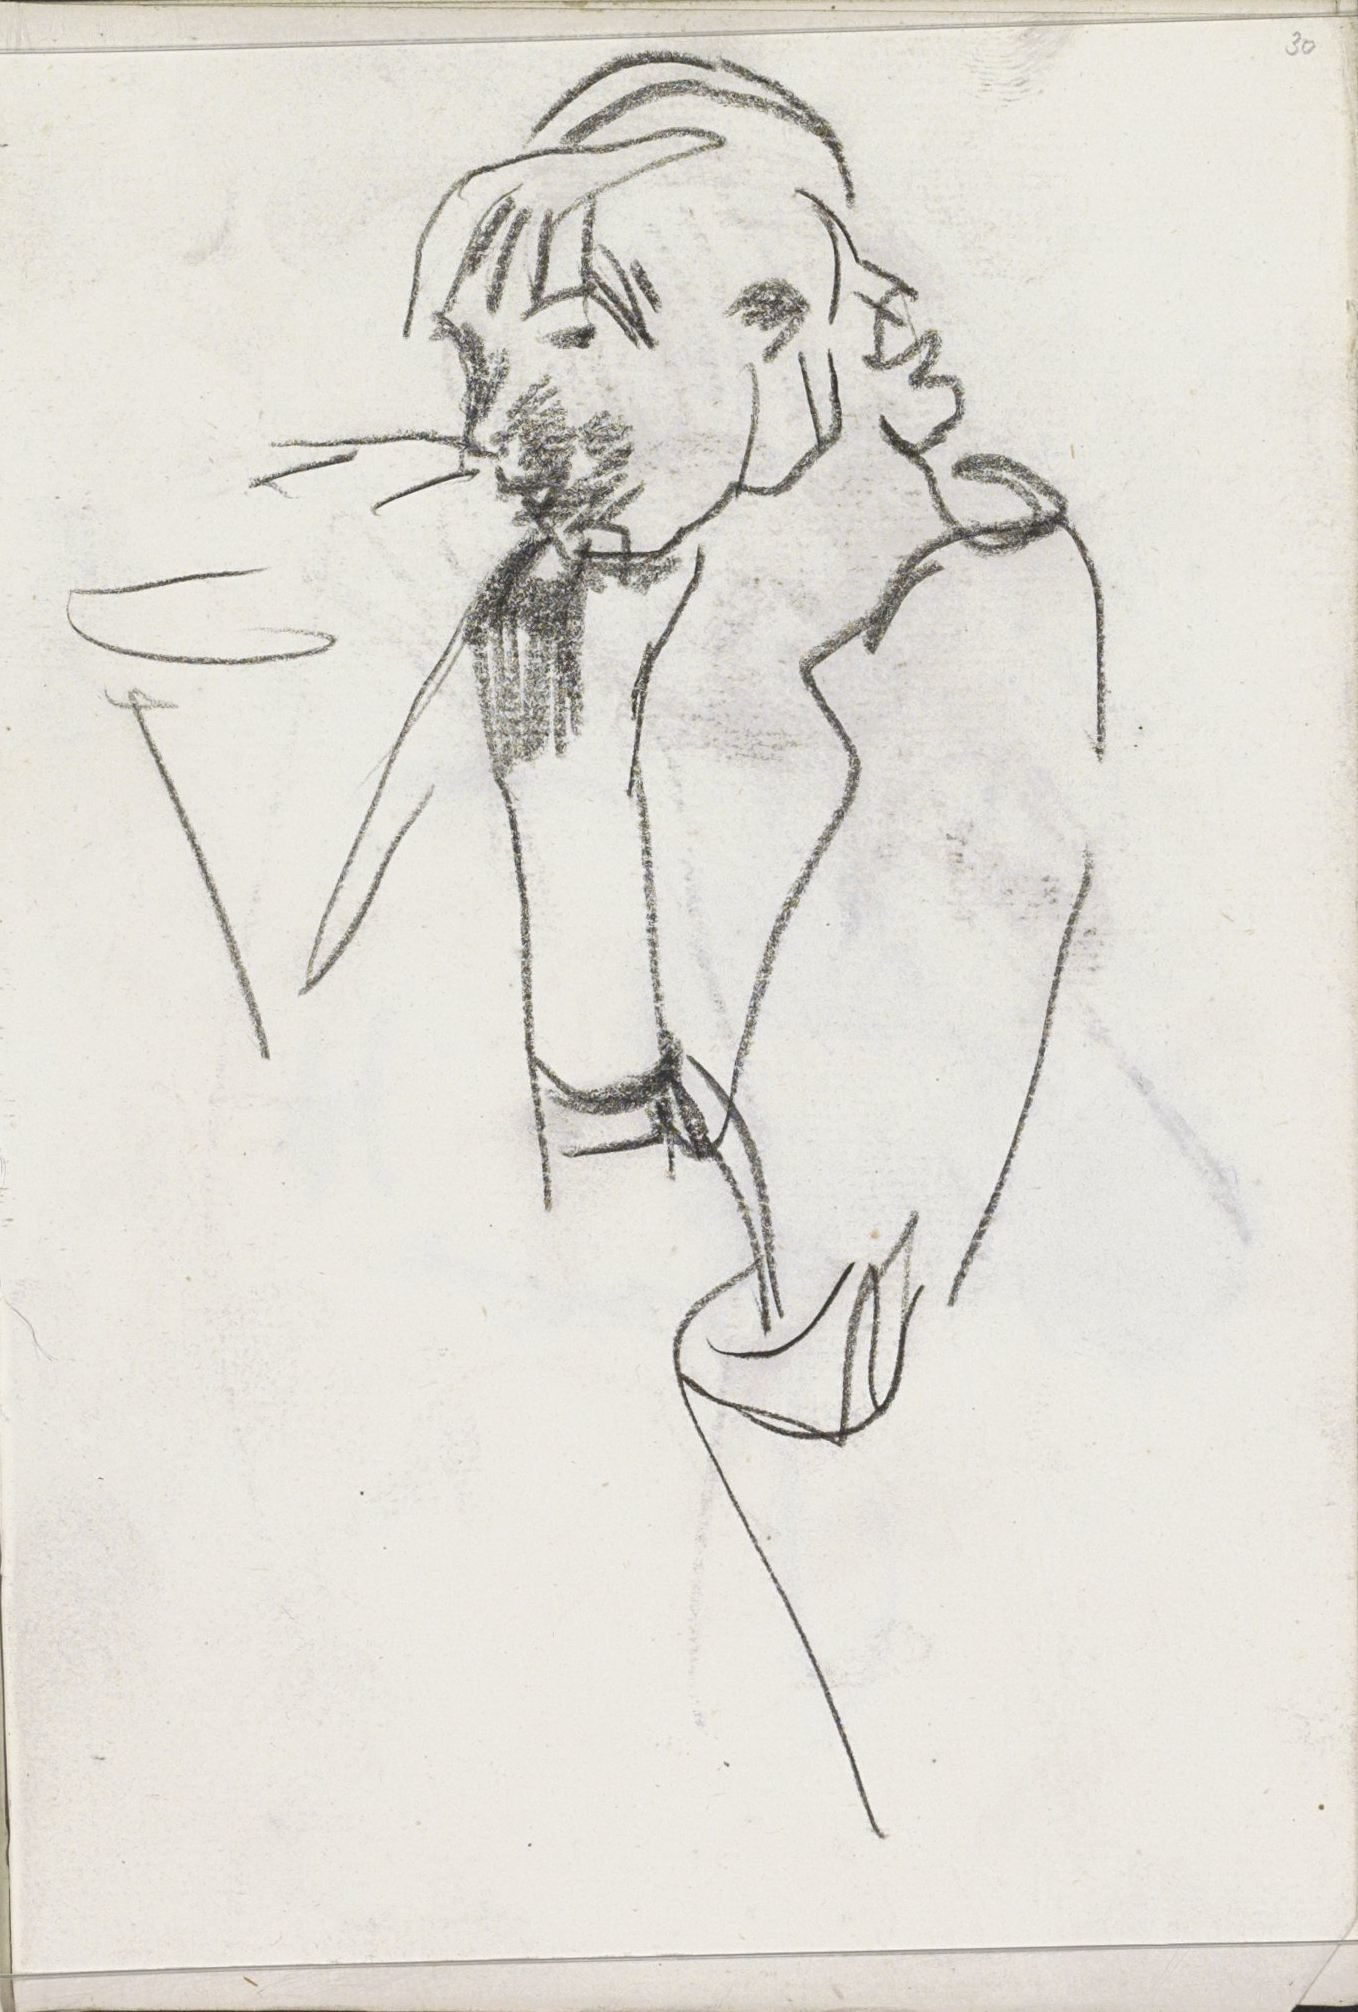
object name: sketchbook leaf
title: Vrouw met een hand onder haar kin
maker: isaac israels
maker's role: draughtsman, painter, print maker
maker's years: 1865-1934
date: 1875-1934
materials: chalk, paper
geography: the hague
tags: adult woman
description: Pagina 30 uit schetsboek XLIV met 43 pagina's.